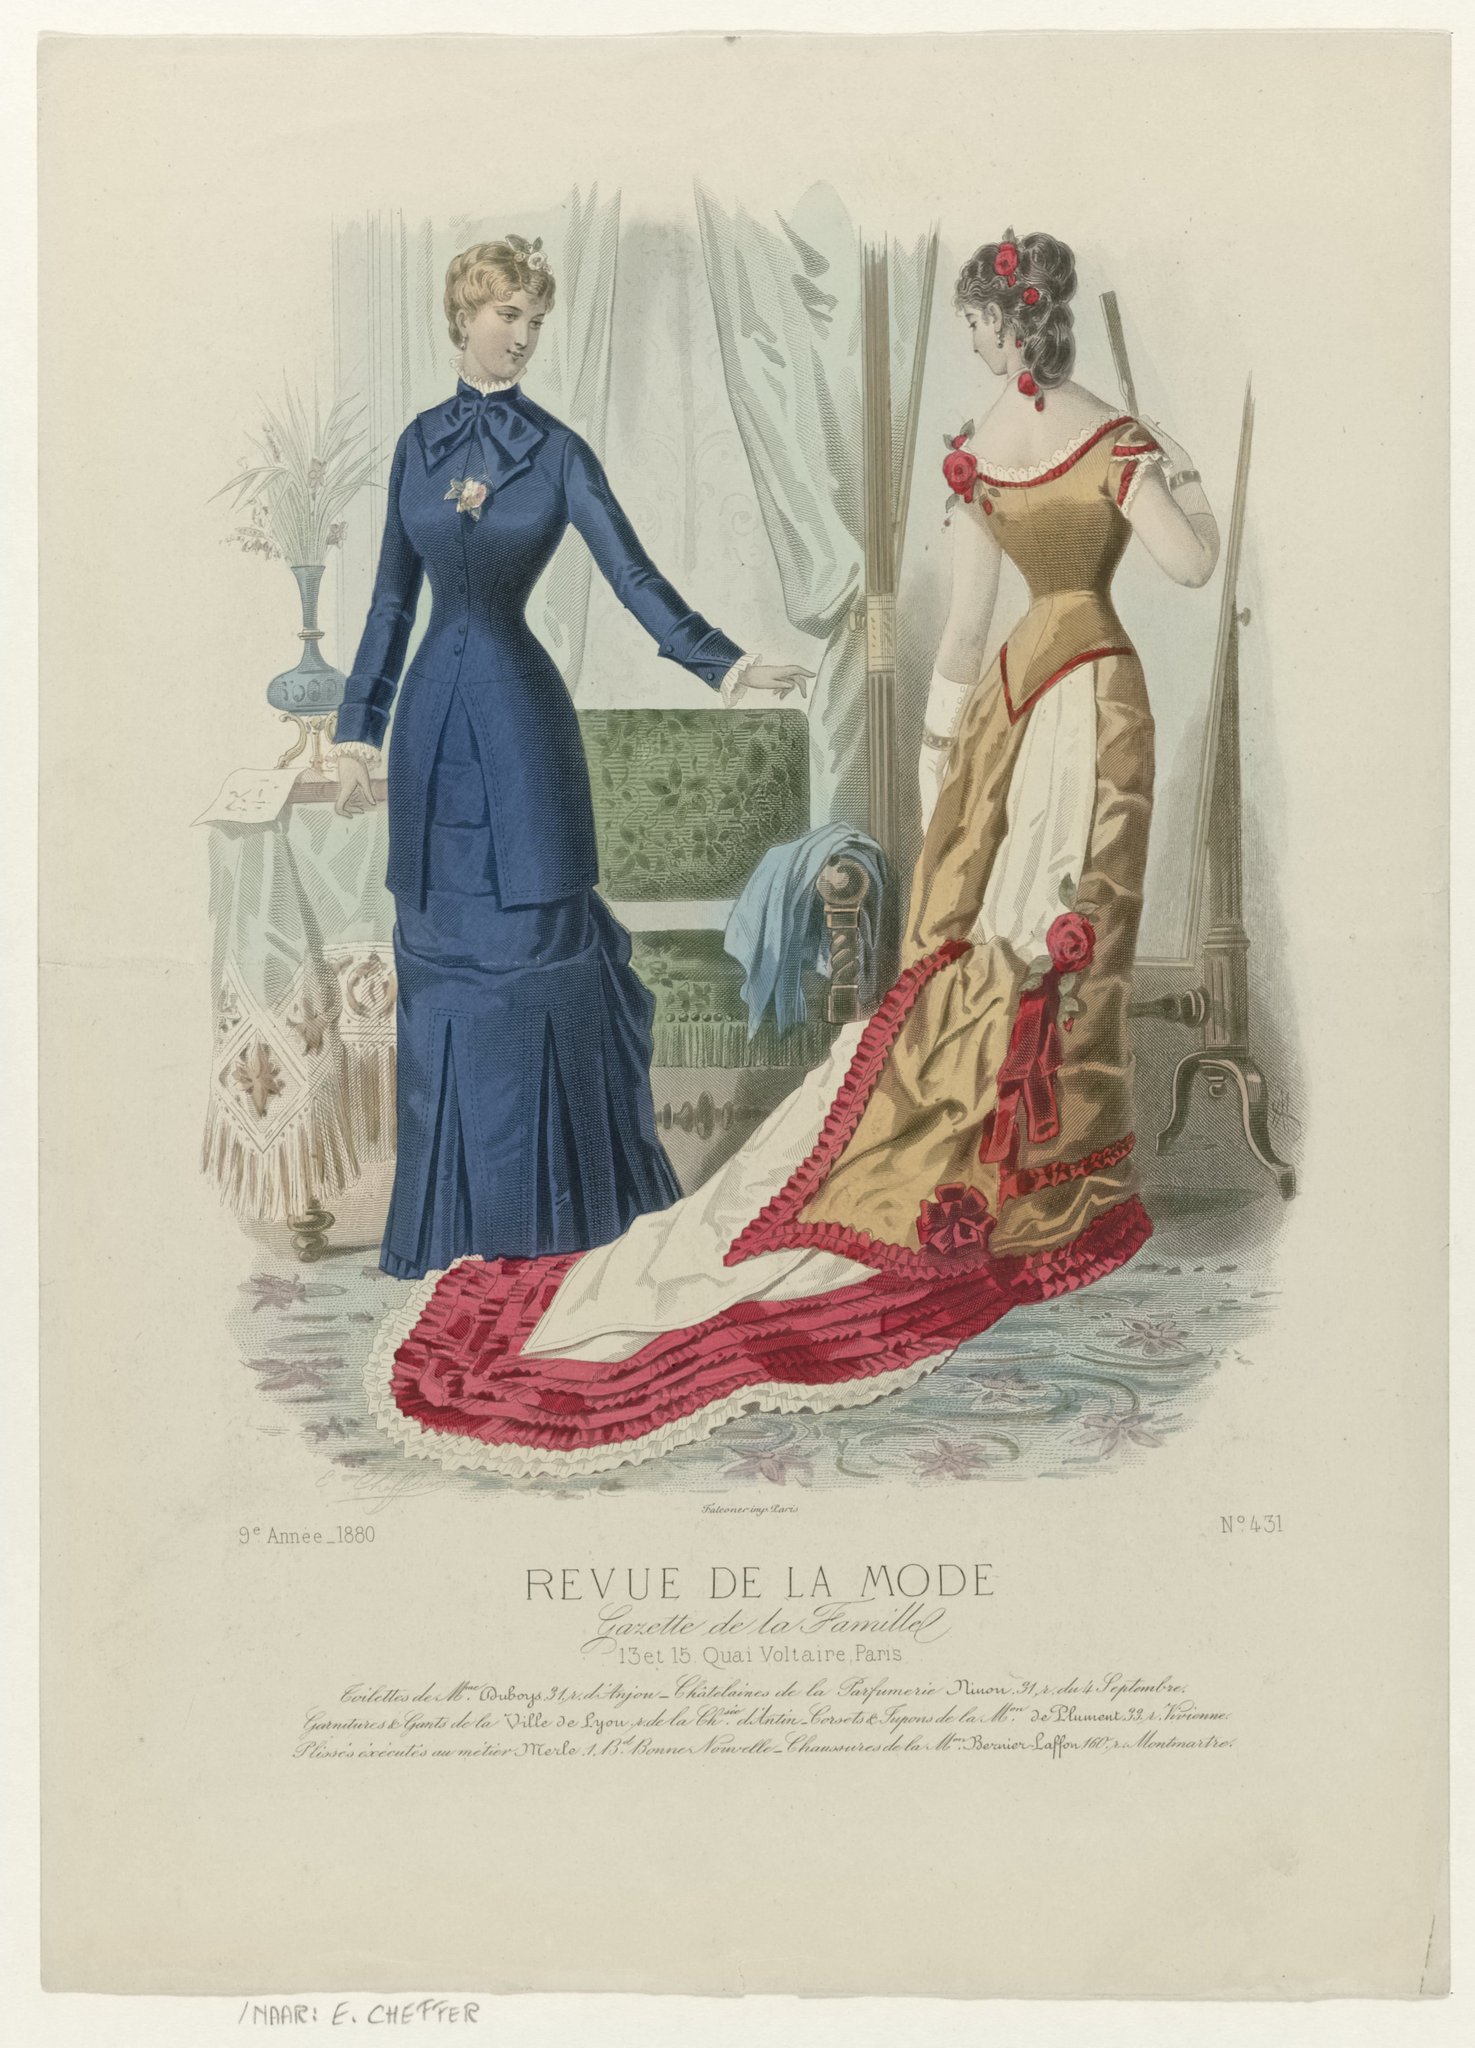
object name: fashion print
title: Revue de la Mode, Gazette de la Famille, dimanche 3 avril 1880, 9e année, No. 431: Toilettes de Mme Duboys (...)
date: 1880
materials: paper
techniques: engraving, hand coloring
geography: paris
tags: corsage (+ women's clothes), flowers, clothing for the upper part of the body (+ women's clothes), dress, gown: evening dress (+ women's clothes), gloves, mittens (long gloves) (+ women's clothes), dress, gown: walking dress (+ women's clothes), neck-gear ~ clothing (revers) (+ women's clothes), dress, gown (robe d'intérieur) (+ women's clothes), mirror - aa - (for) women, fashion plates, skirt (+ women's clothes), dress, gown (+ women's clothes), fan (+ women's clothes), bracelet, wristlet (+ women's clothes)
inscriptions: caption: ‘Toilettes de M.me Duboys. 31.r. d'Anjou_ Châtelaines de la Parfumerie Ninon. 31.r. du 4 Septembre. Garnitures & Gants de la Ville de Lyon, r. de la Ch.sée d'Antin_ Corsets & Jupons de la M.on de Plument. 33. r. Vivienne. Plissés éxécutés au métier Merle. 1. Bd Bonne Nouvelle_Chaussures de la M.on Bernier-Laffon. 160. r. Montmartre.’, address: ‘13 et 15, Quai Voltaire, Paris’, title: ‘REVUE DE LA MODE / Gazette de la Famille’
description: Twee vrouwen in een interieur, gekleed in japonnen van Duboys. De vrouw voor de passpiegel draagt een japon van wit, goudkleurig en rood satijn, voor een soirée. Naast haar staat een vrouw in een blauwe japon, geschikt voor de wandeling of om binnenshuis te dragen. Onder de afbeelding enkele regels reclametekst voor verschillende producten. Prent uit het modetijdschrift Revue de la Mode (1872-1913). Uitgebreide beschrijving van de kleding op pagina 118 "PLANCHE COLORIÉE".